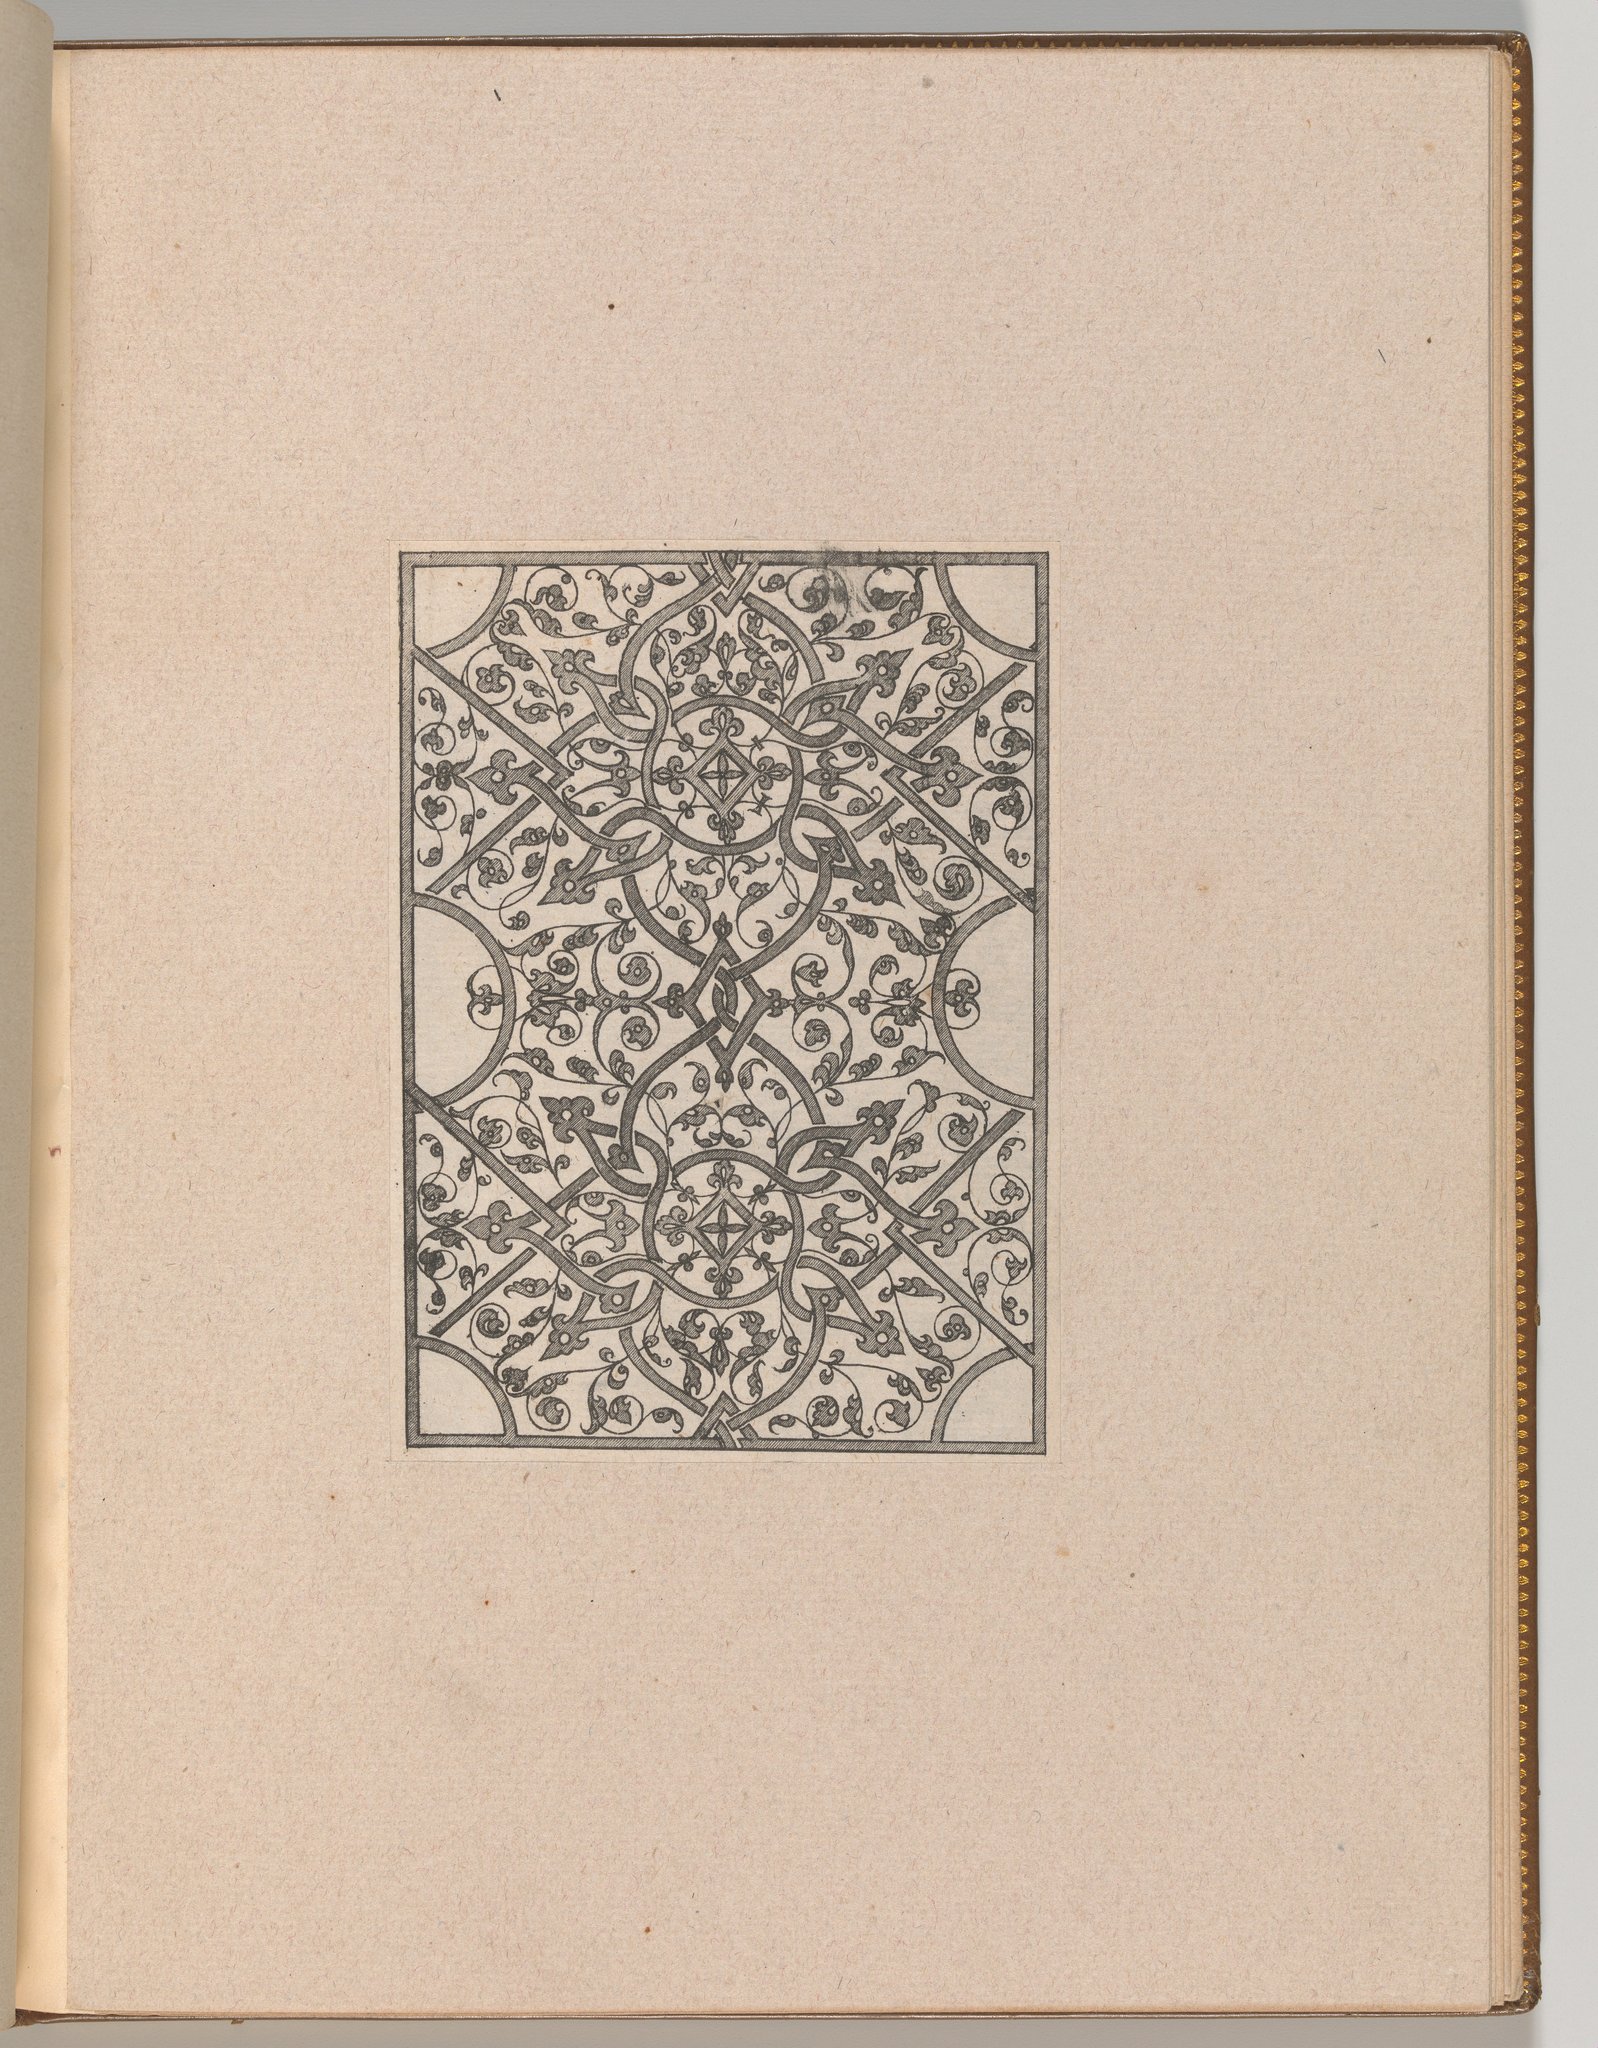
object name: album print ornament architecture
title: Copies after the 'Livre contenant passement de moresques' (plate 1)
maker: jacques androuet du cerceau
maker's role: artist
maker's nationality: french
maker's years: 1510-1585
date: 1801-1900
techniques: etching